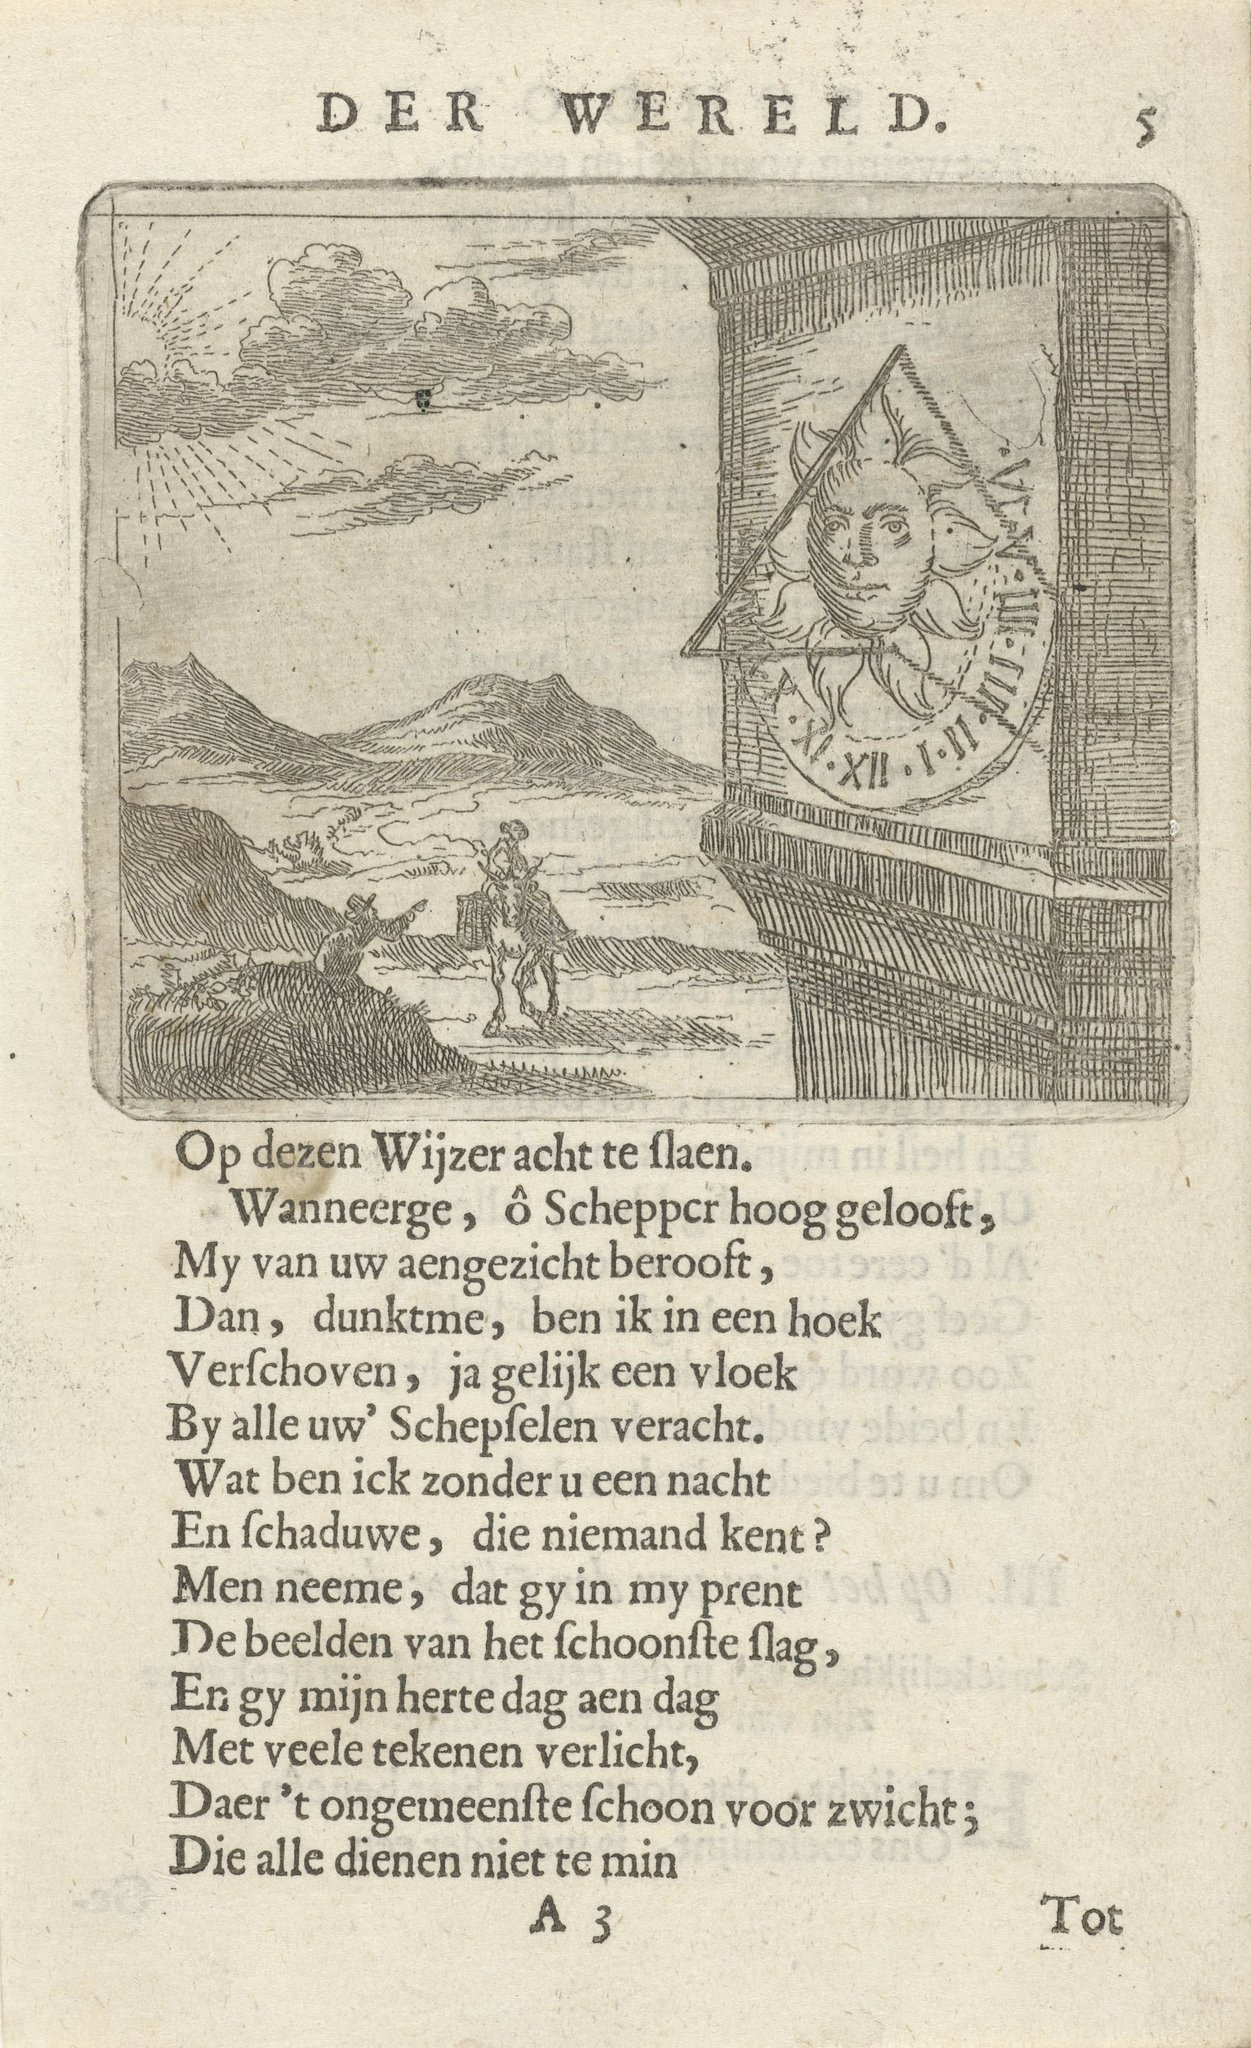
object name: book illustration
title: II. Op het zien van een Zonnewijzer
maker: arnold houbraken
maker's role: draughtsman, painter, print maker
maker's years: 1660-1719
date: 1682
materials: paper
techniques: etching, letterpress printing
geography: northern netherlands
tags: sun as celestial body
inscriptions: collector's mark: Lugt 2228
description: Prent uit: Joseph Hall, [bewerkt door] François van Hoogstraeten, De schoole der wereld, geopent in CXL. vliegende bedenkingen op veelerhande voorvallende gezichten en zaeken. Dordrecht: François van Hoogstraeten, 1682. En in herdrukken in 1687 en 1725.